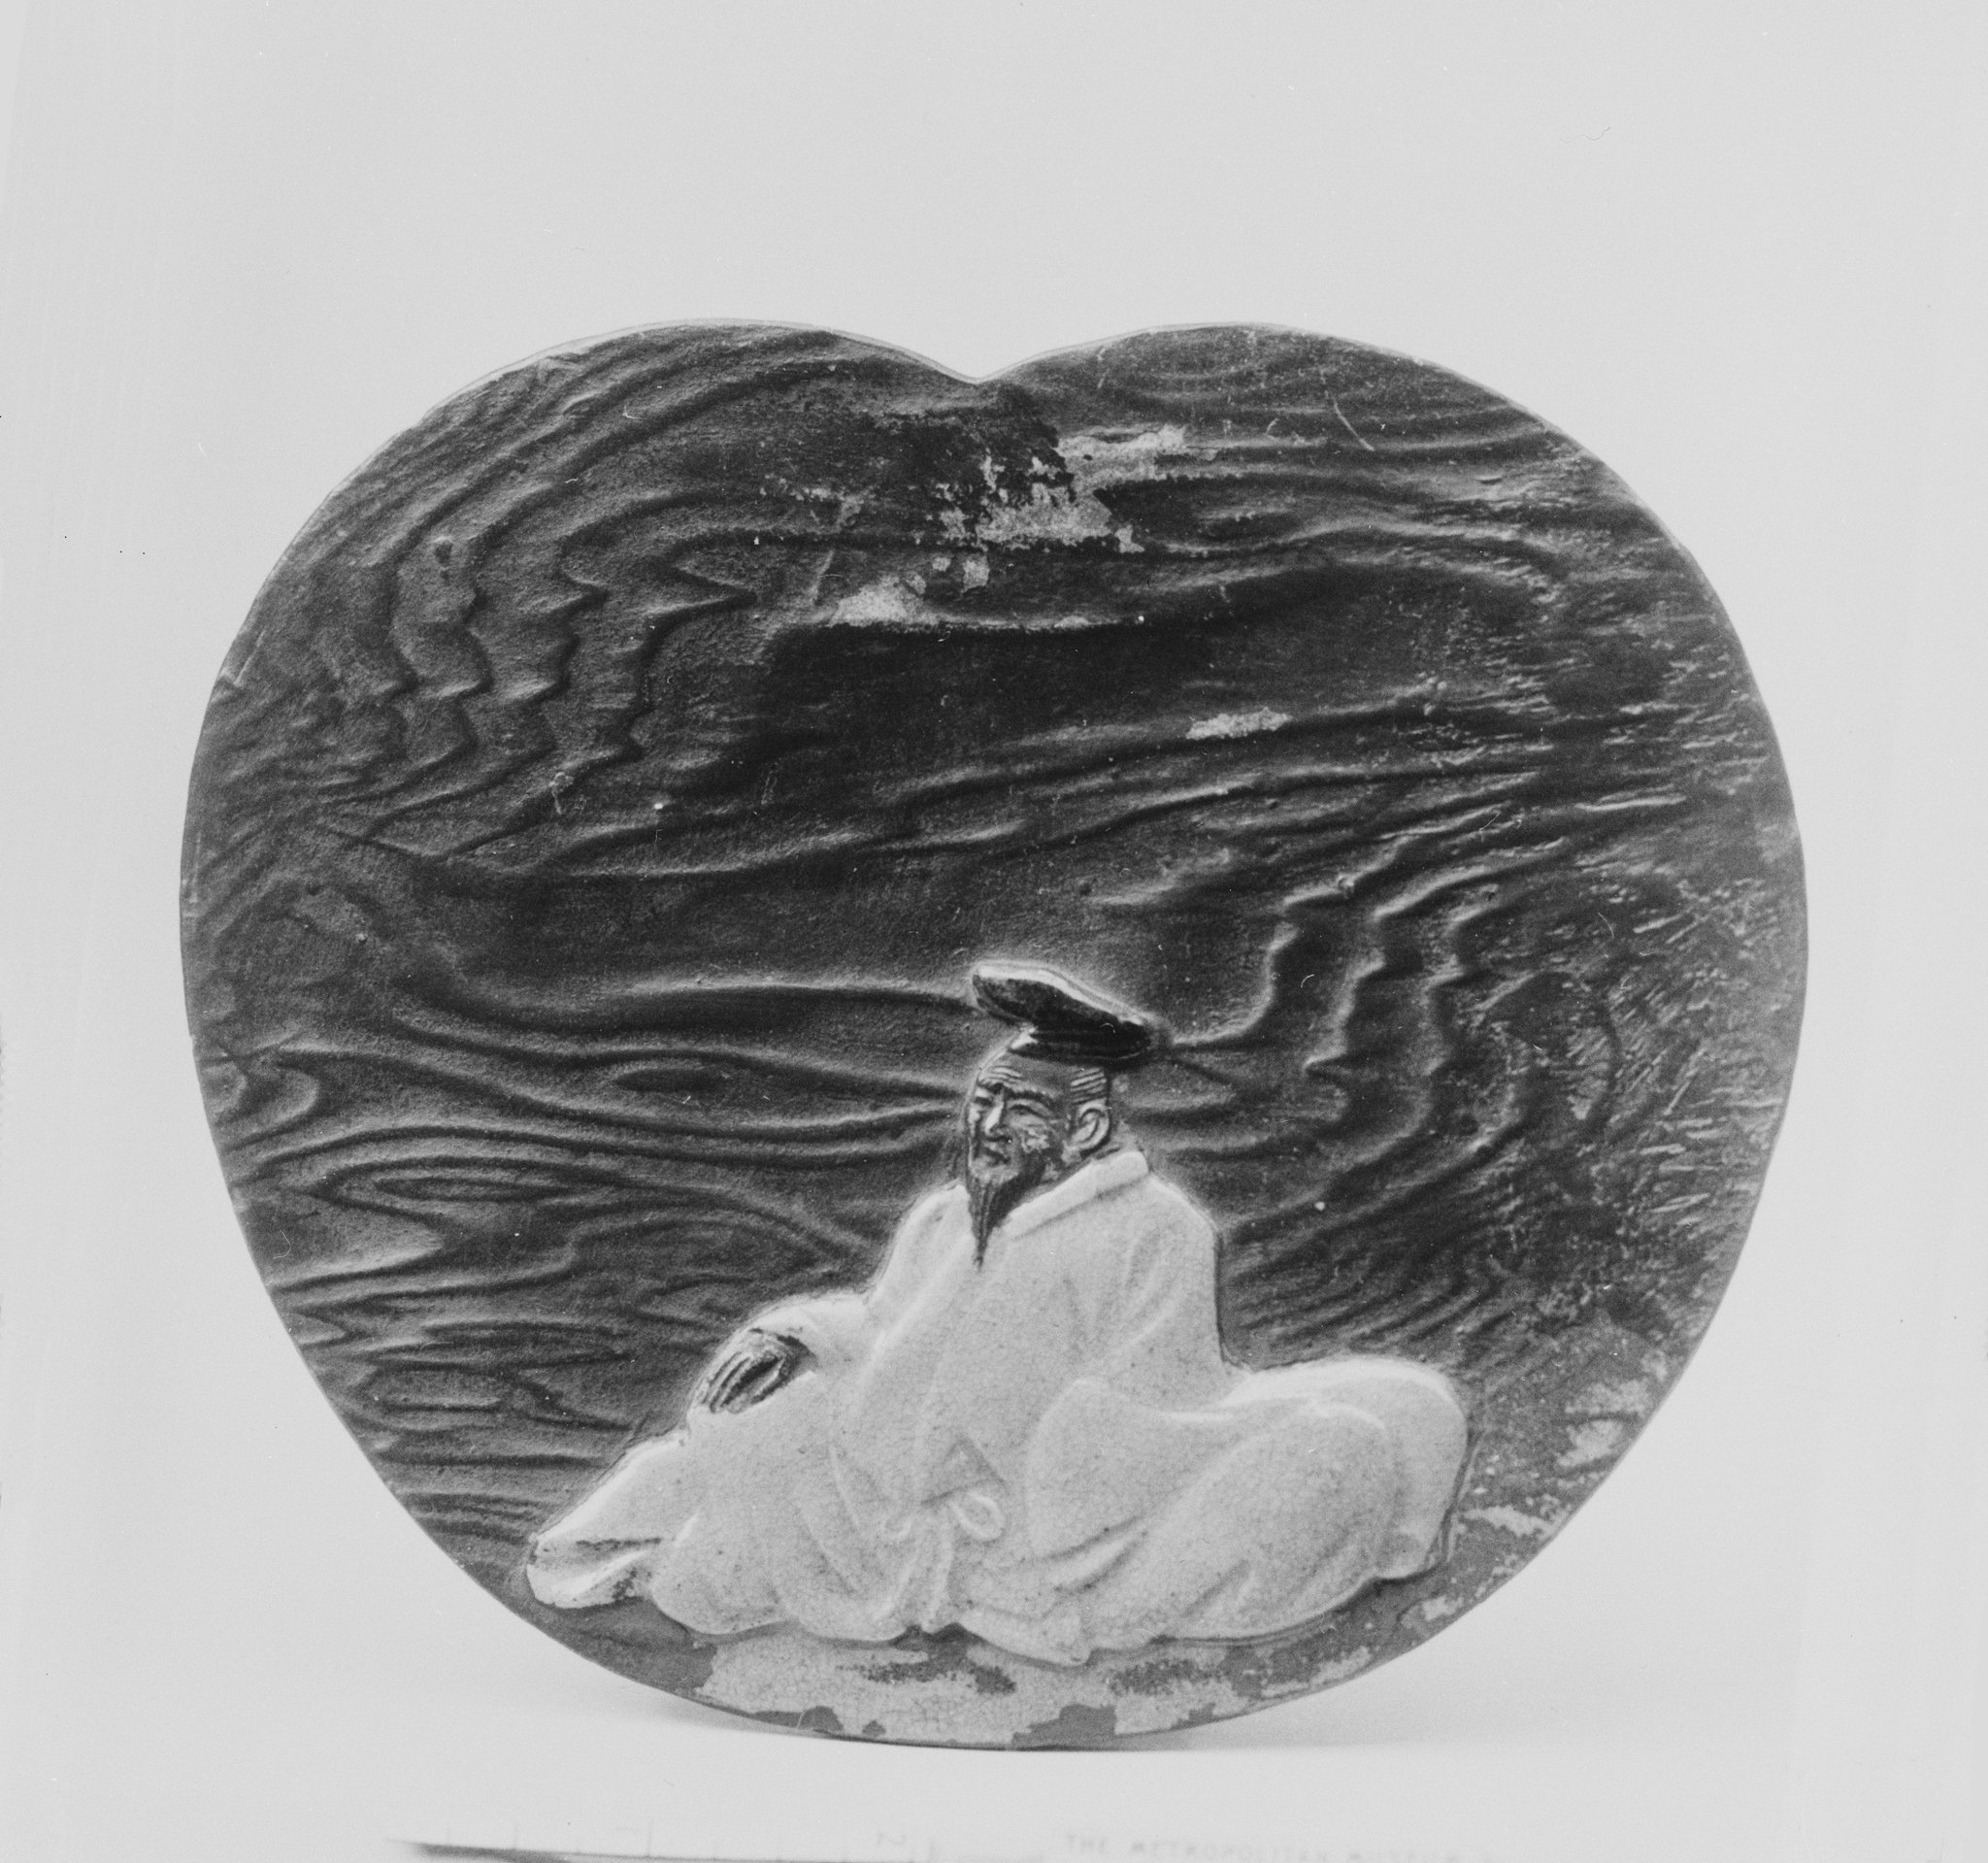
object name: vase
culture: japanese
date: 1750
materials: enamel, faience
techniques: relief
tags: men